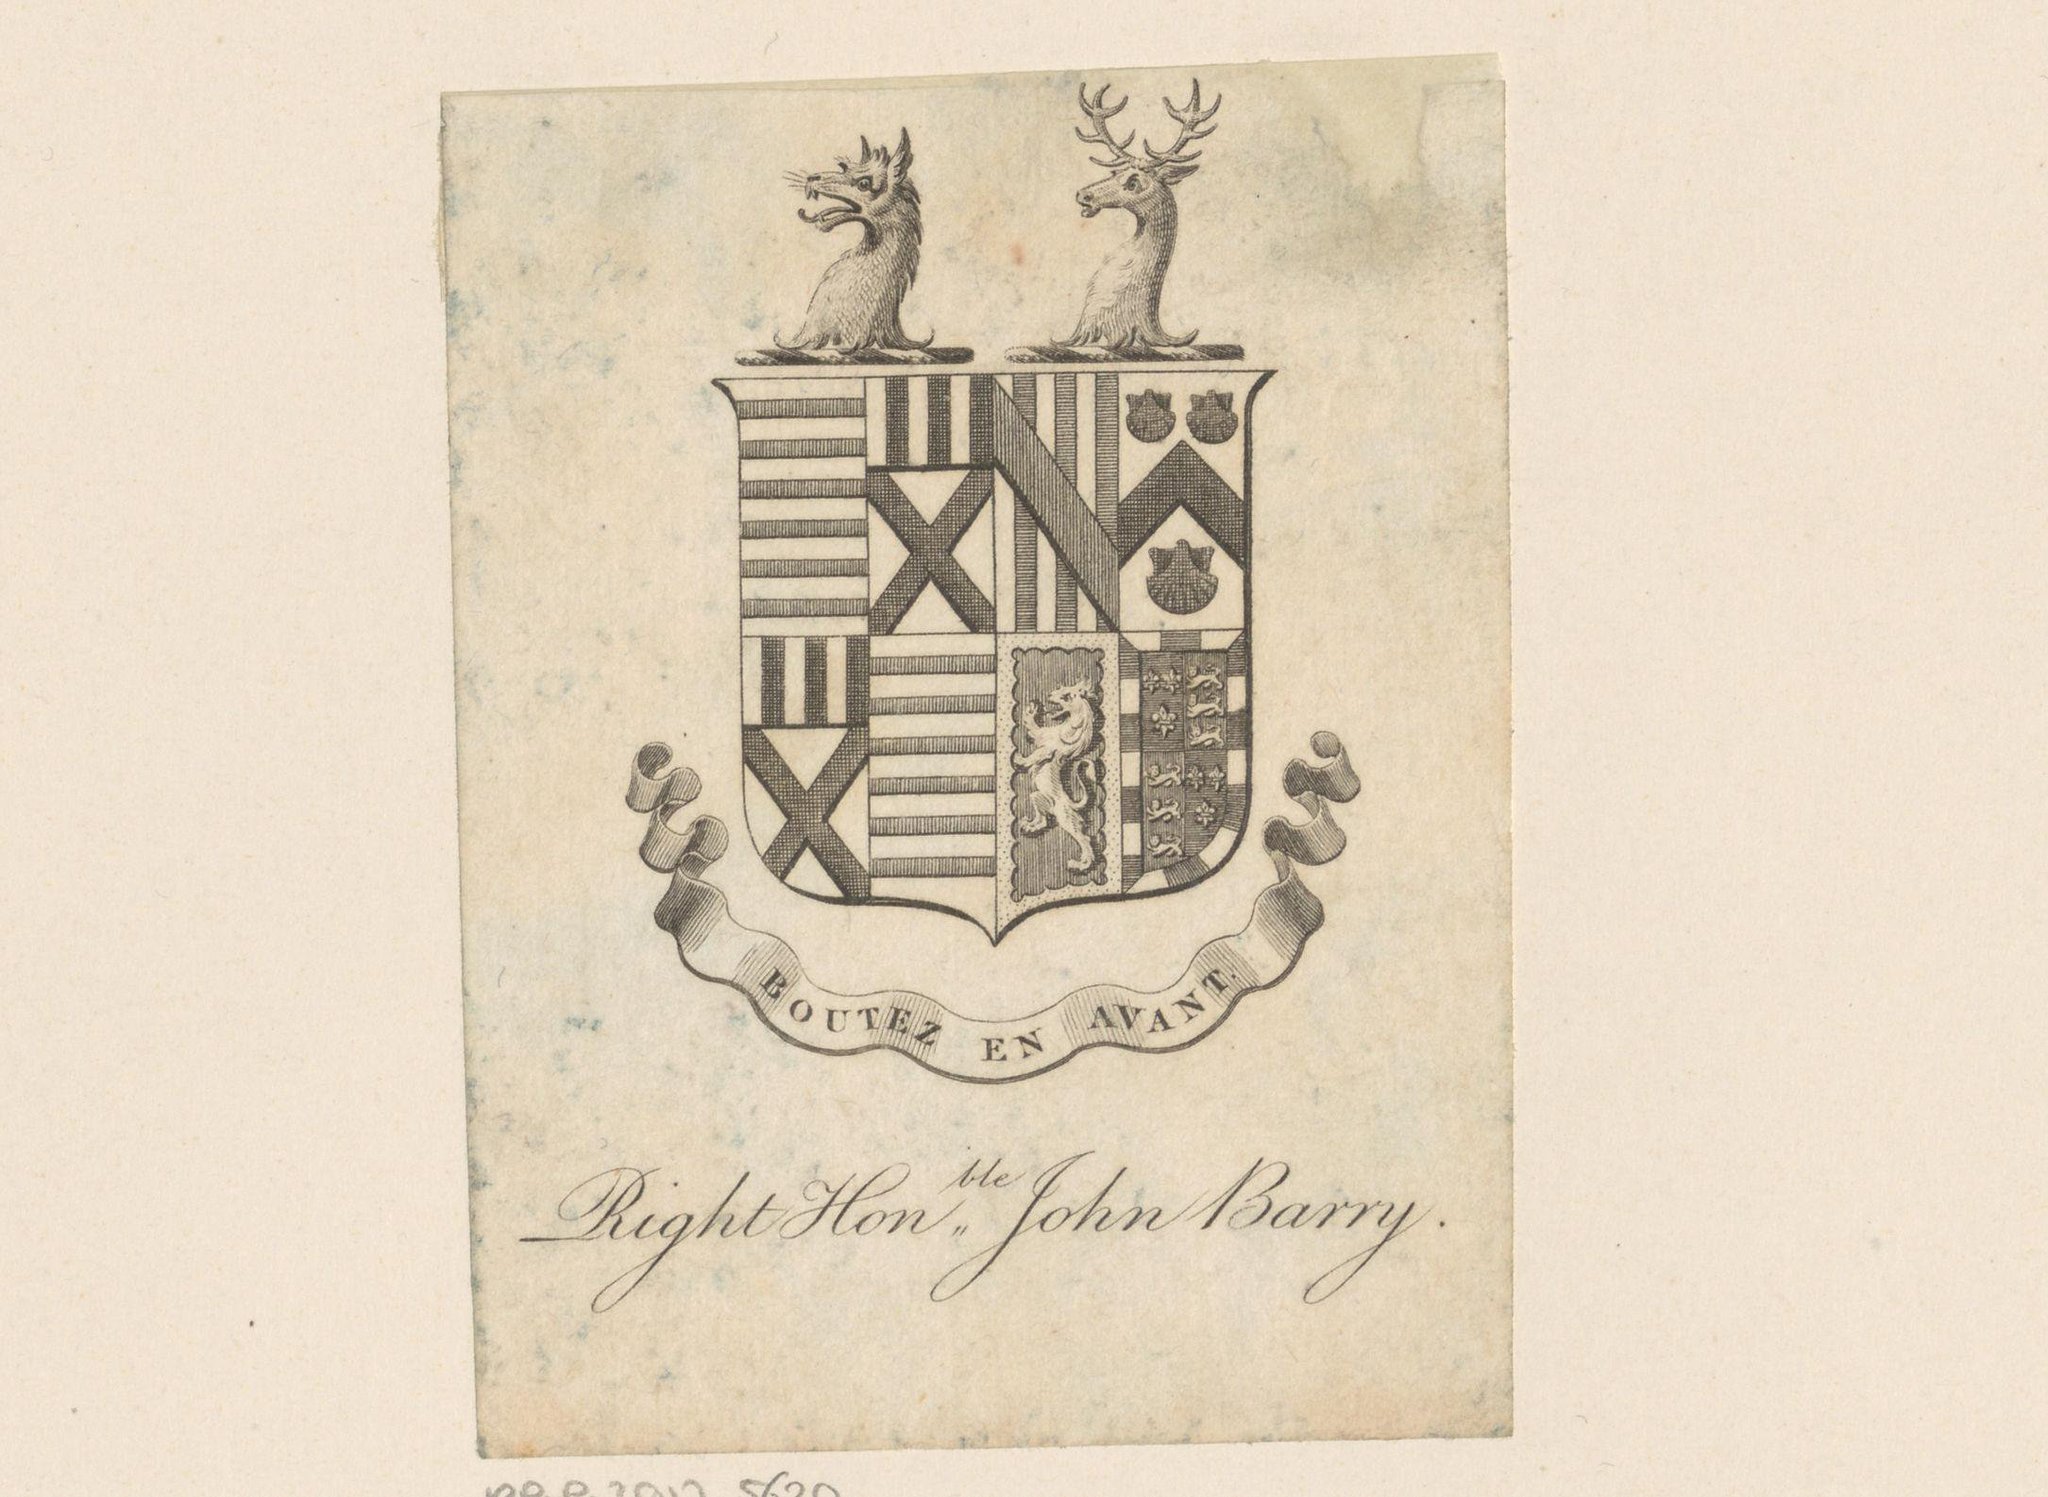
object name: bookplate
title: Ex libris van John Barry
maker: Anonymous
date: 1750-1849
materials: paper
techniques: etching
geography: england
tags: hoofed animals: stag, armorial bearing, heraldry